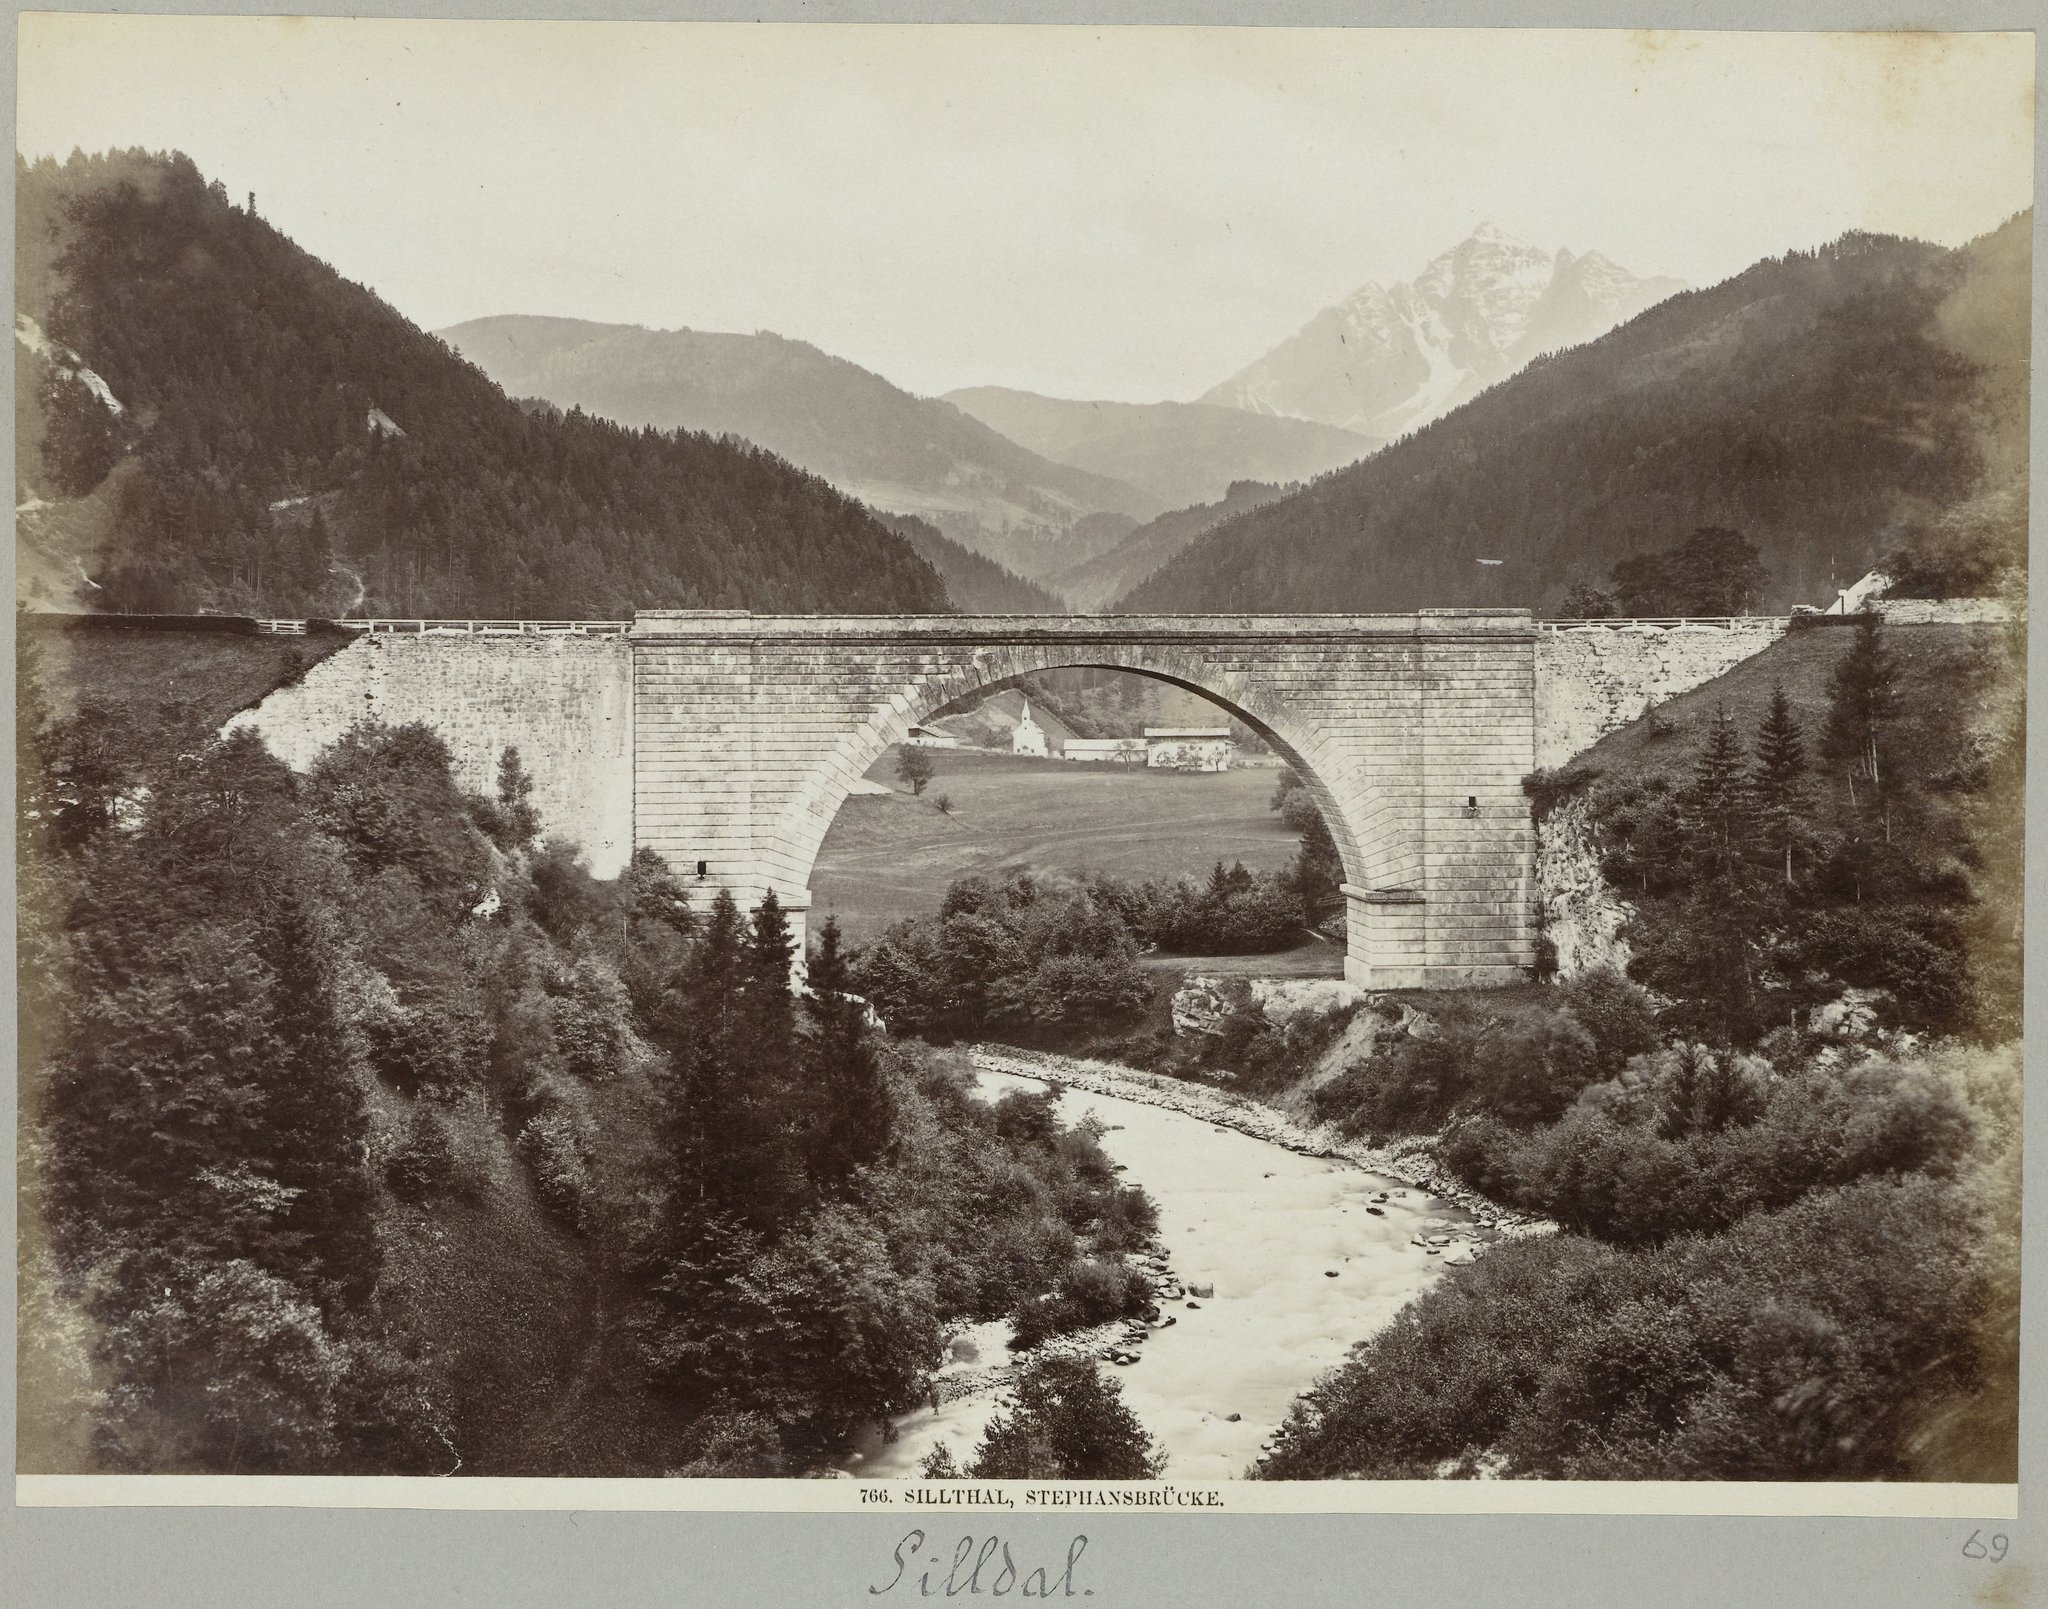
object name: photograph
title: Silldal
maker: Anonymous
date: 1893-1903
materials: cardboard, photographic support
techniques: albumen print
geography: austria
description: Gezicht op het berglandschap en de Stephansbrug rondom het Silldal.